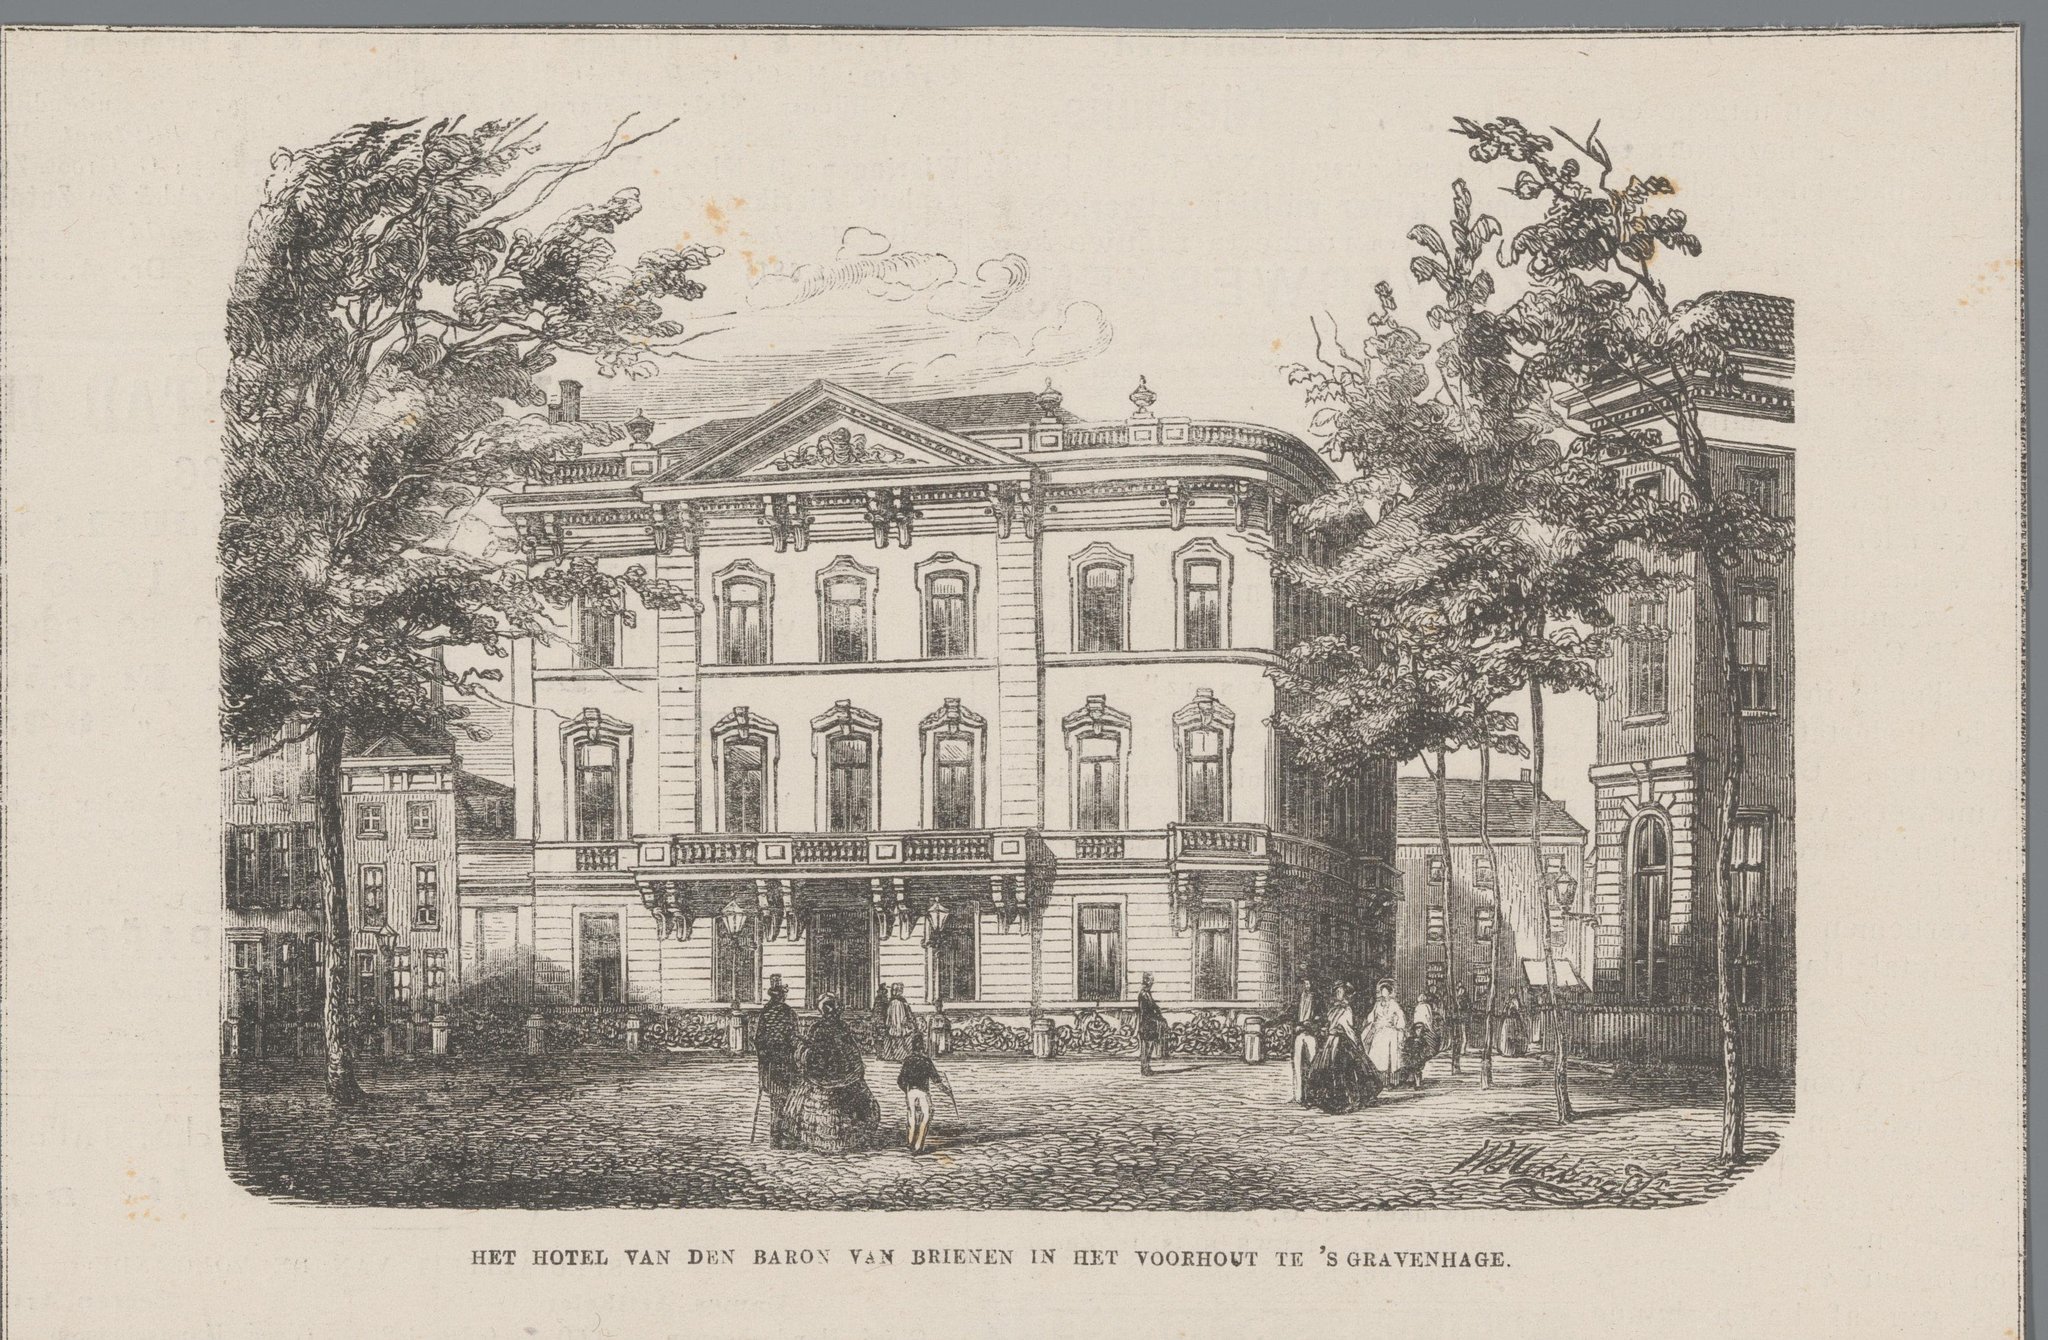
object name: print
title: Het Hotel, van den baron van brieven in het voorhout te 's Gravenhage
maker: Anonymous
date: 1880-1930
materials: paper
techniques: letterpress printing, engraving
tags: civic architecture; edifices; dwellings, the hague